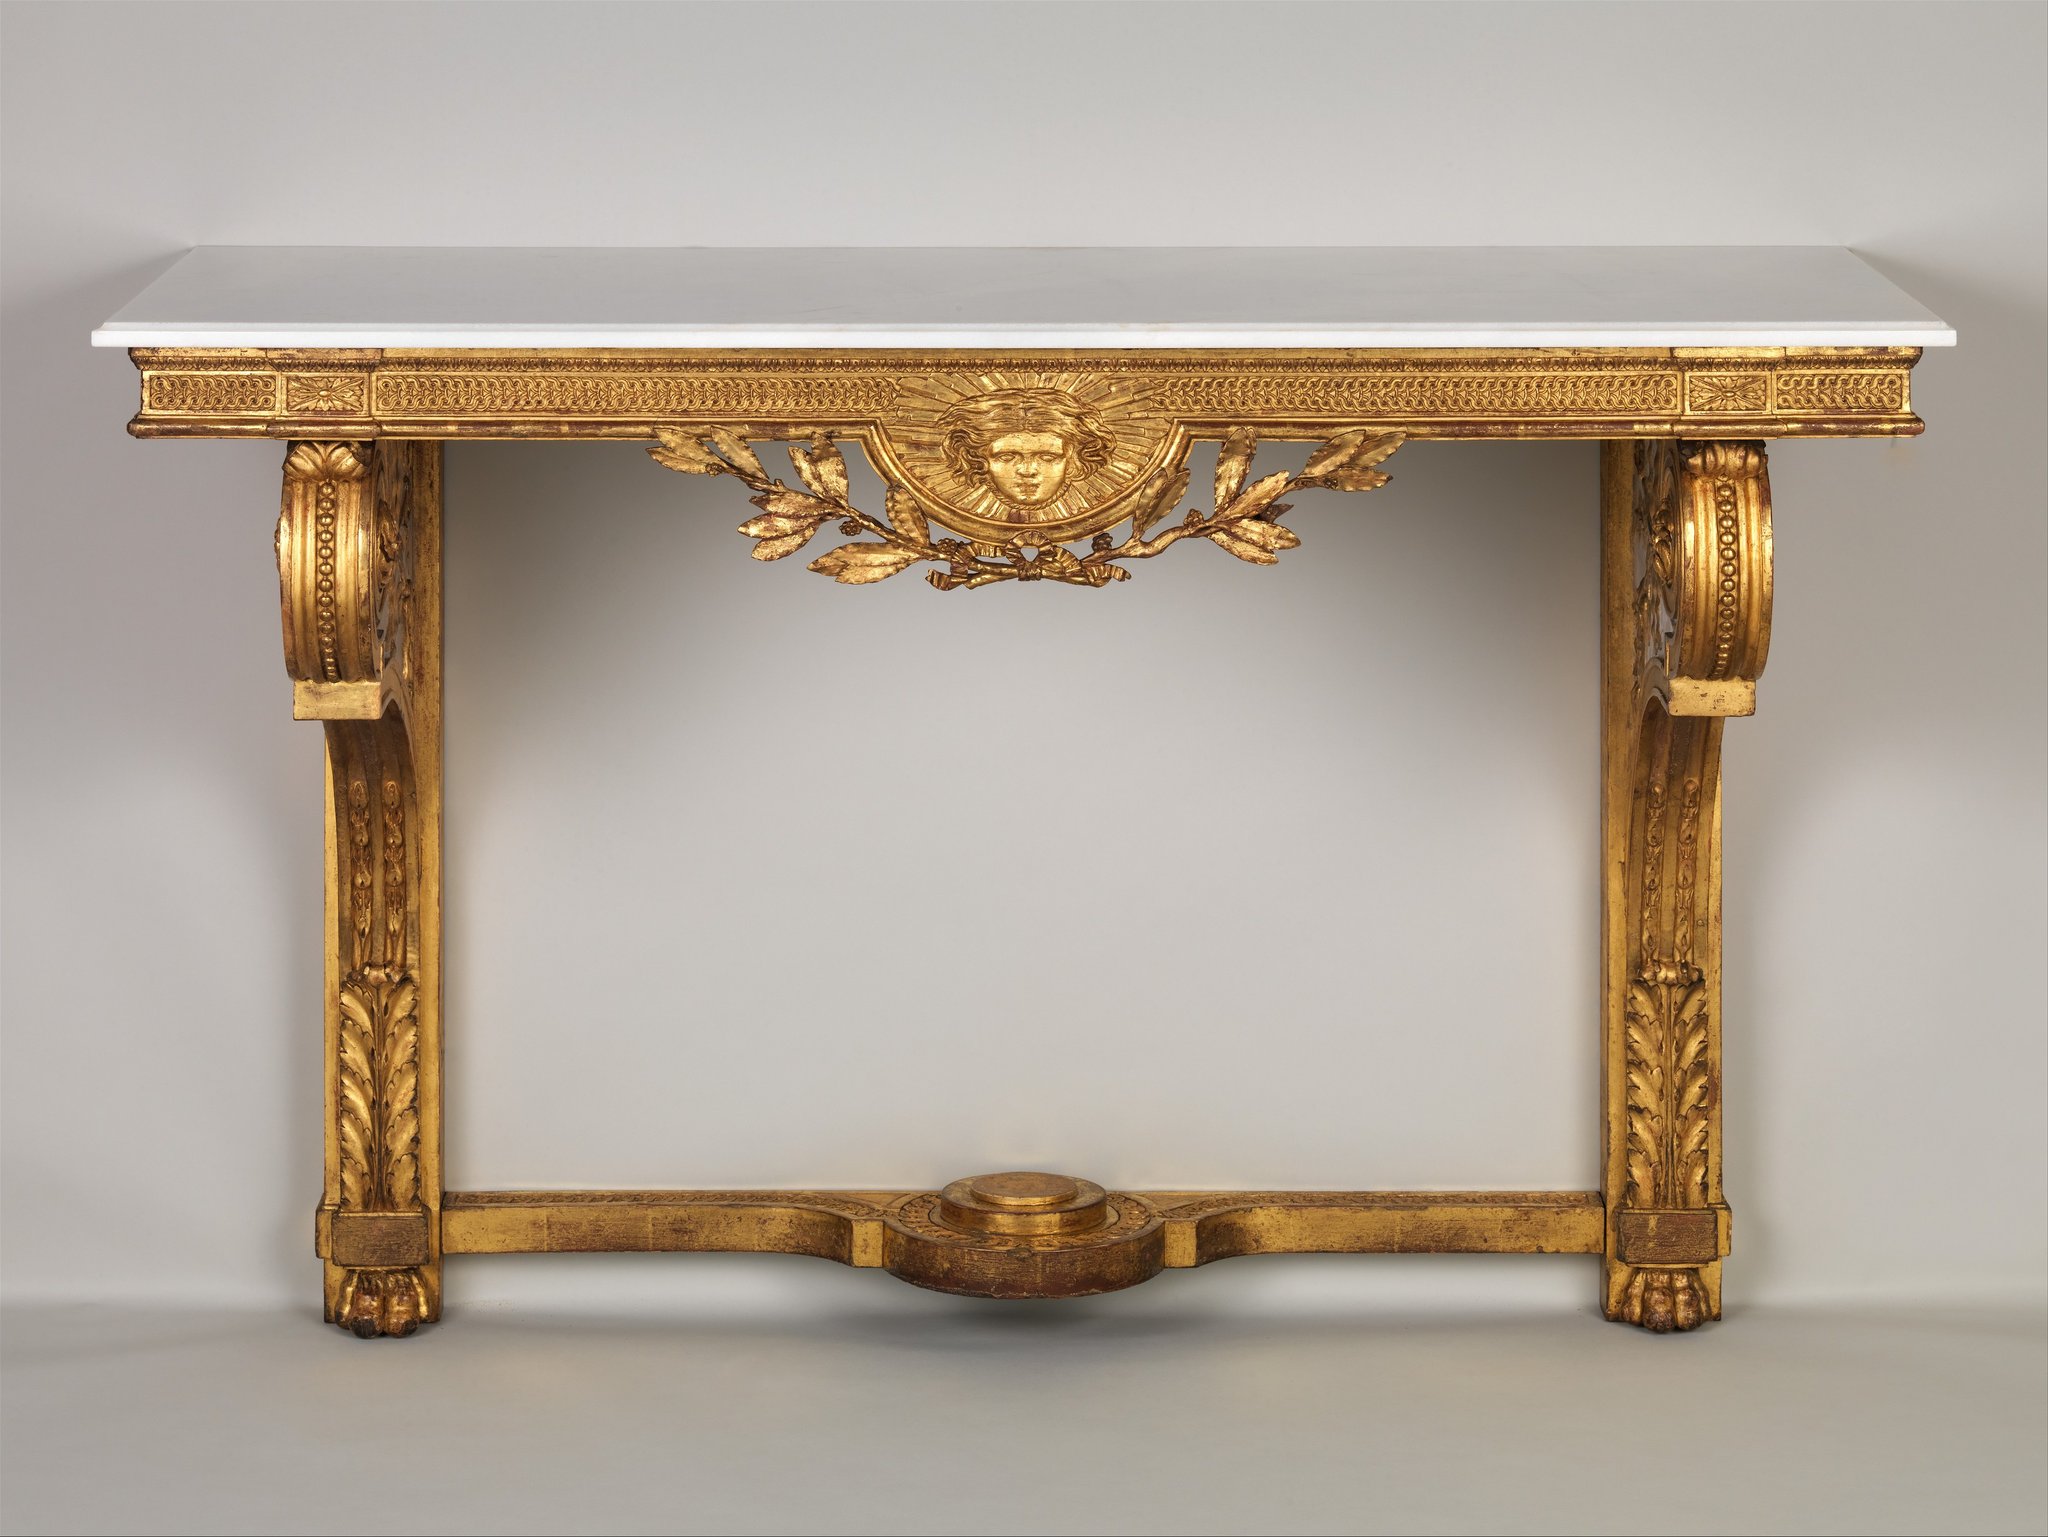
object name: console table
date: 1775-1780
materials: marble, wood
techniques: carving, gilding, painting